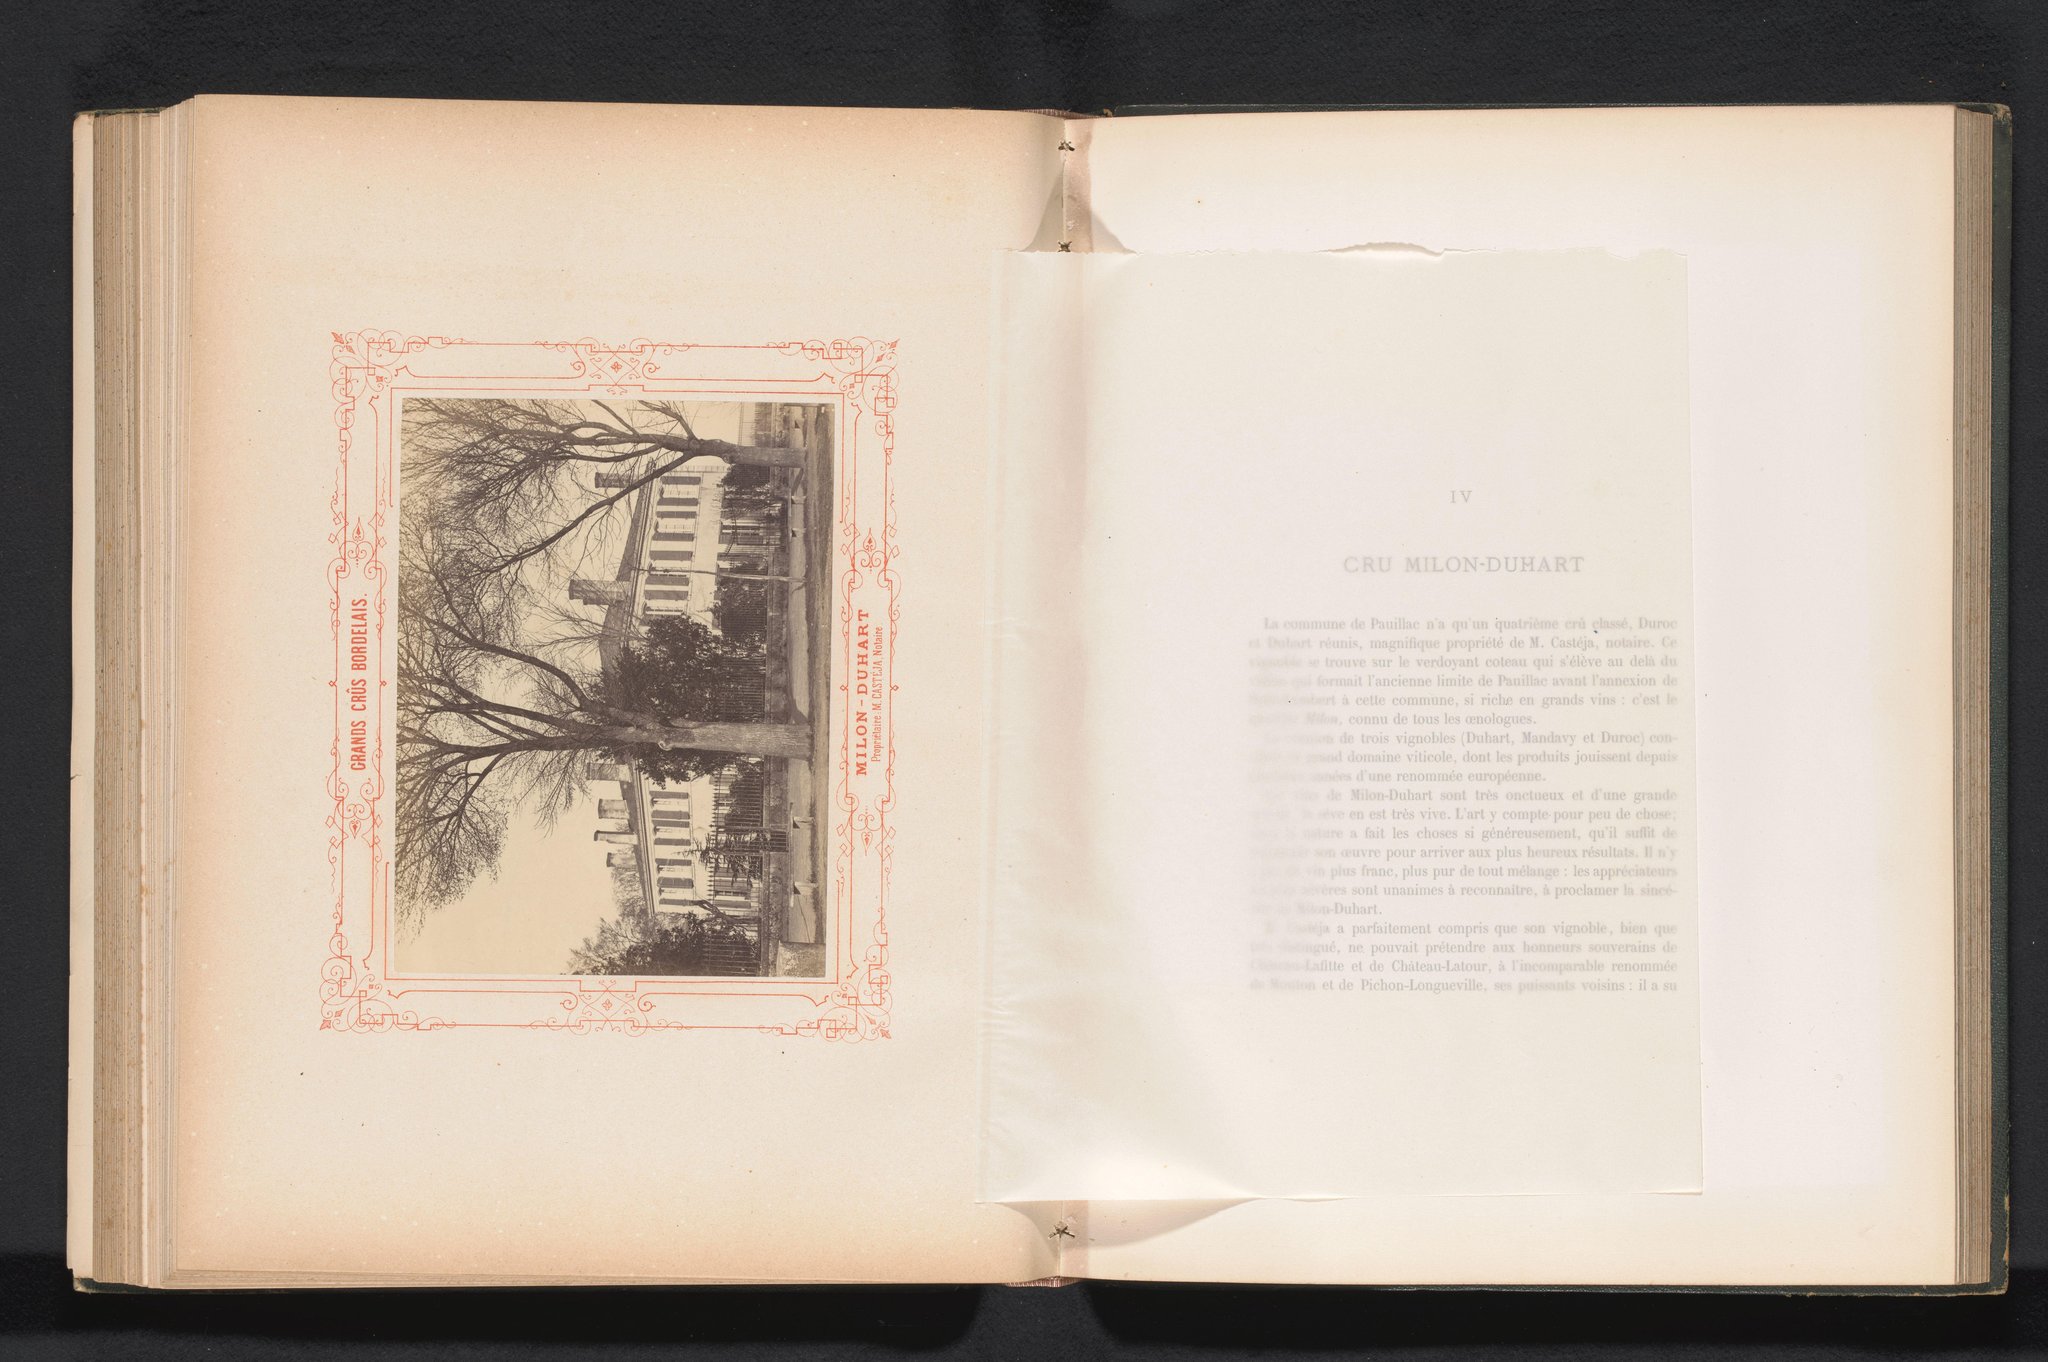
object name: photograph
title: Gezicht op Château Duhart-Milon in Pauillac, Frankrijk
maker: alfred danflou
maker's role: fotograaf, schrijver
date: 1862-1867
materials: photographic support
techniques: albumen print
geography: pauillac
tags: castle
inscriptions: inscription: ‘Propriétaire: M. CASTÉJA, Notaire.’